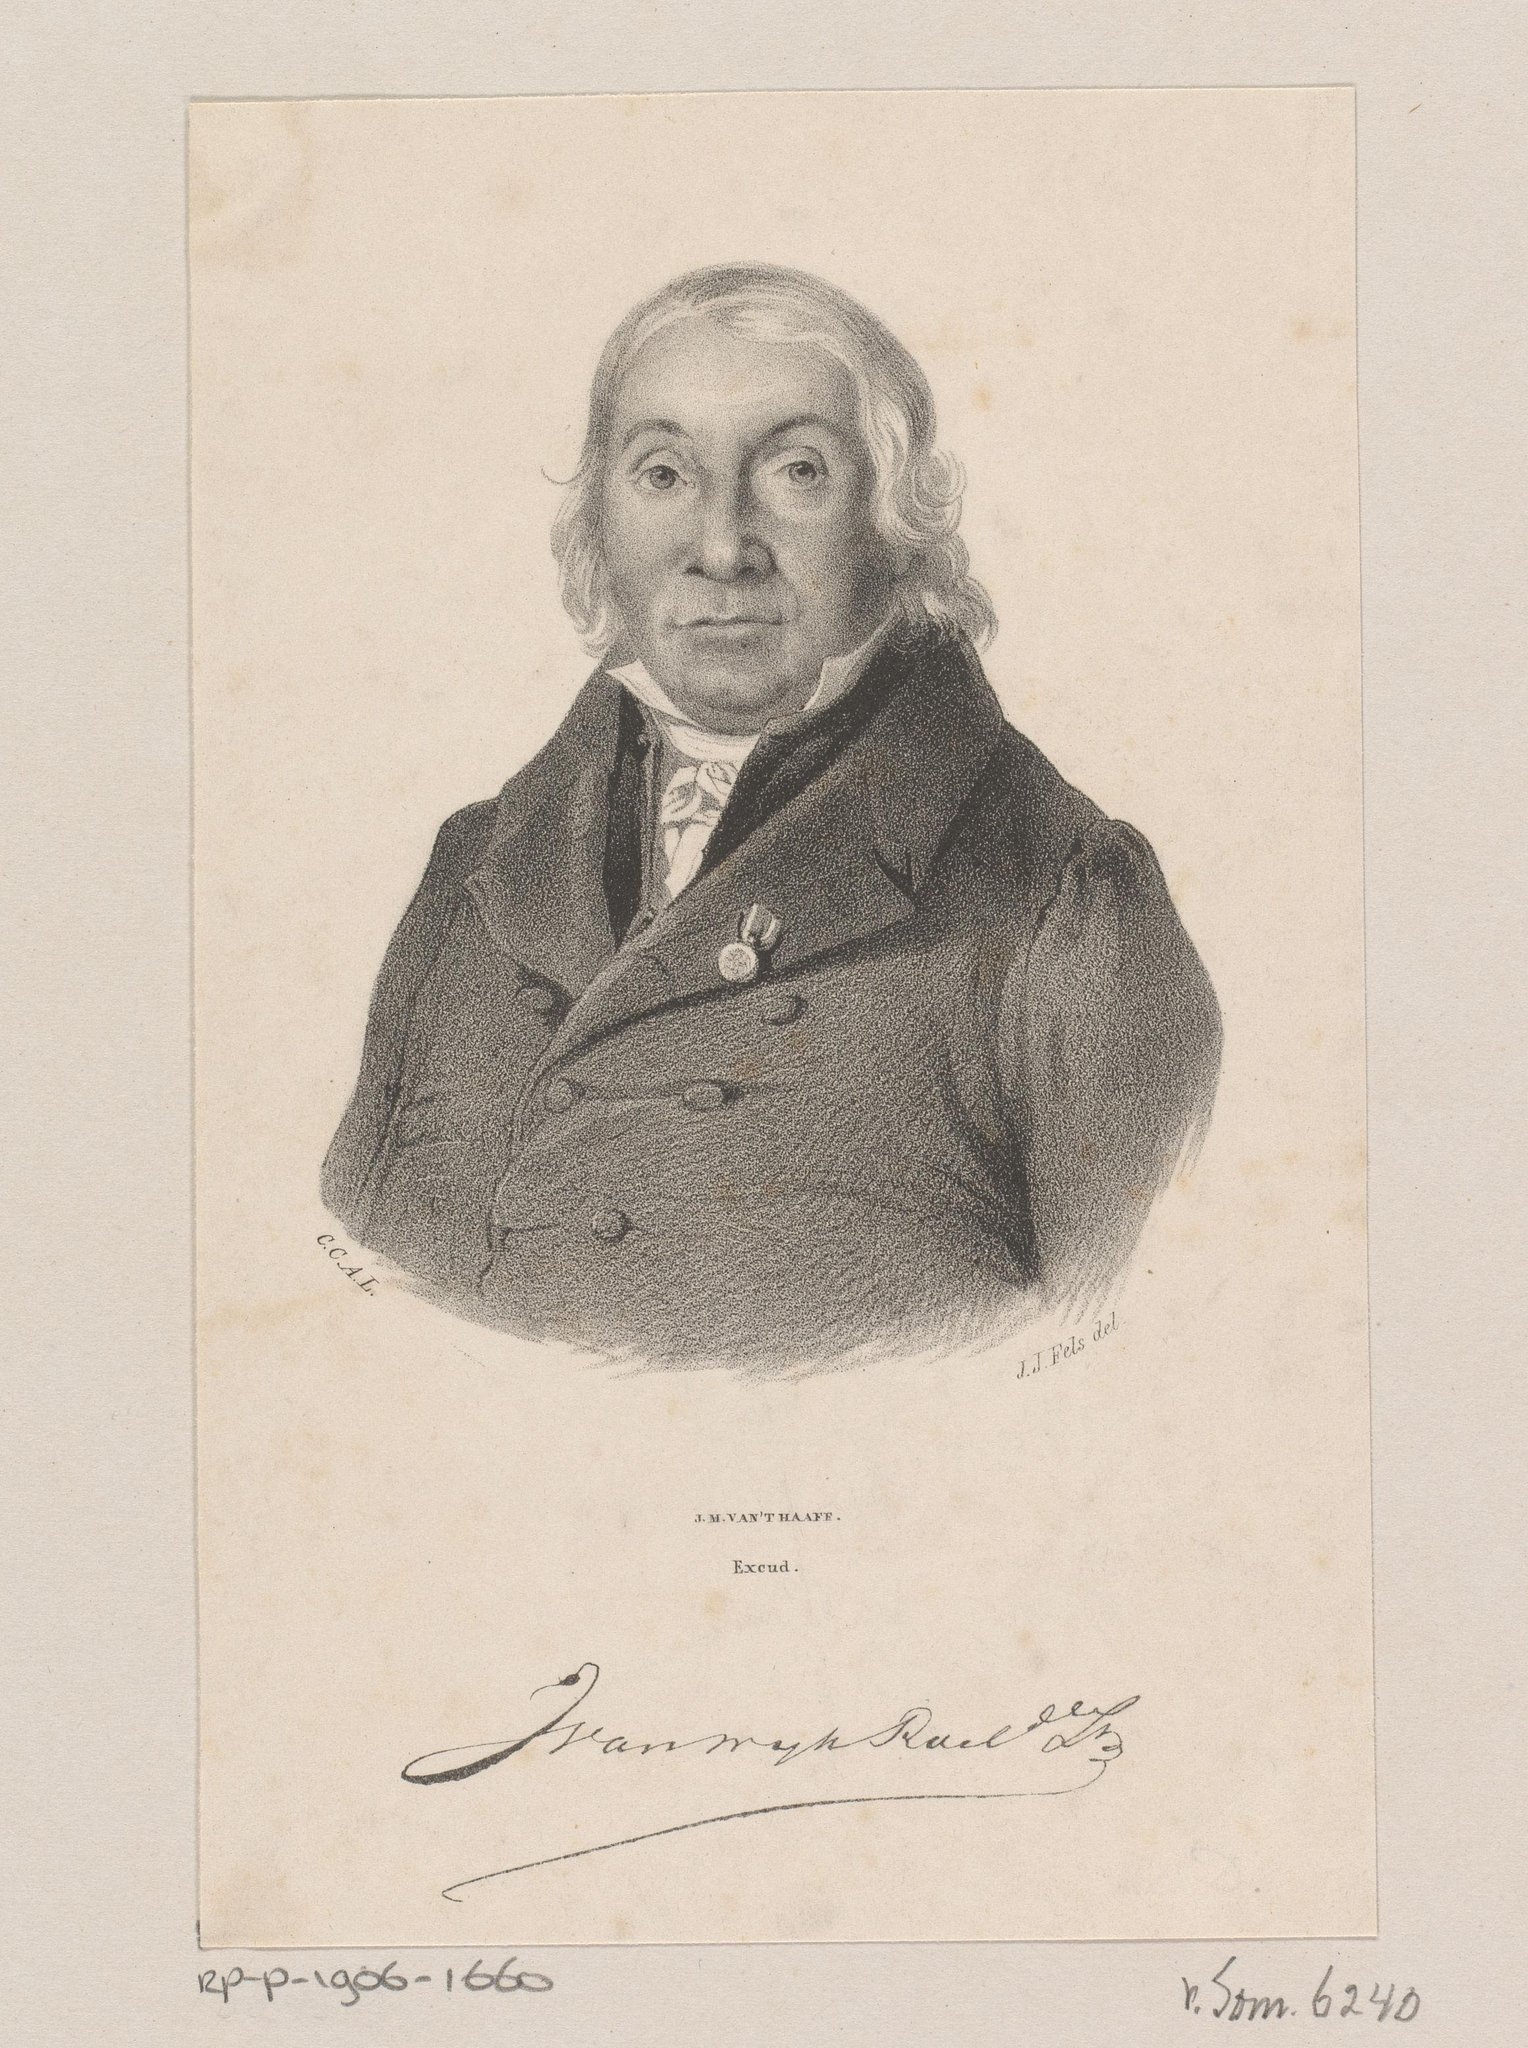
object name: book illustration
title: Portret van Jacobus van Wijk Roelandszoon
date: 1845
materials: paper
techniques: lithograph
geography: the hague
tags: jacobus van wijk roelandszoon, historical persons, elementary school; class, form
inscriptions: collector's mark: Lugt 2228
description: Prent waarschijnlijk uit: Buddingh, D. Jaarboekje voor hooger-, middelbaar- en lager onderwijs. Den Haag: J.M. van 't Haaff, 1845, dl. 3.